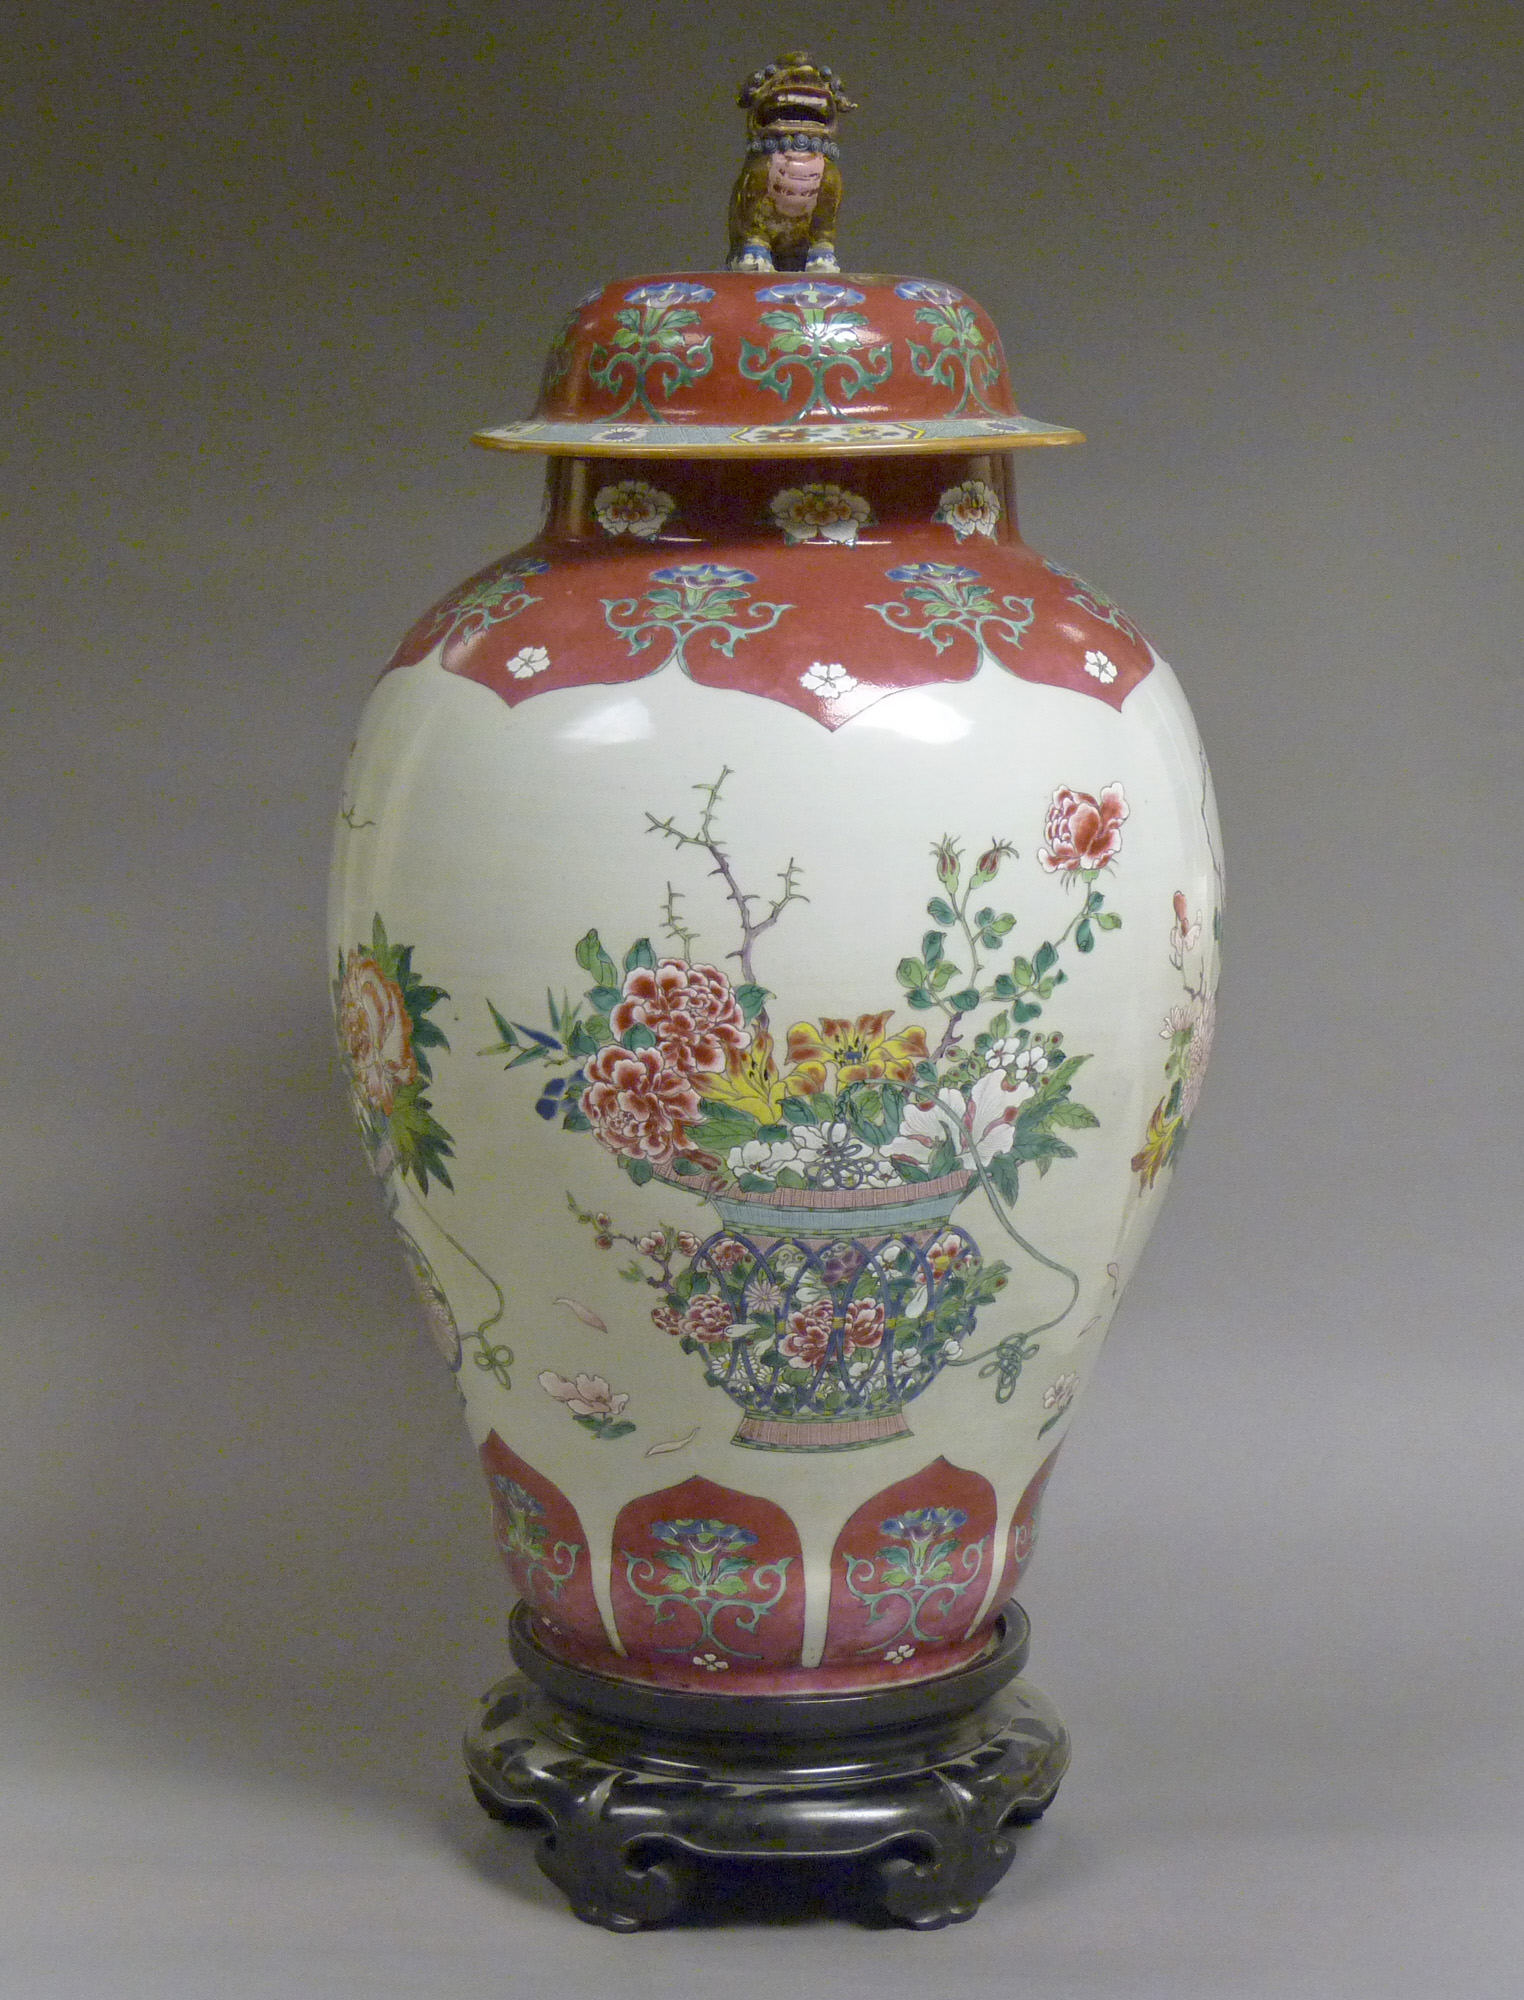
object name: jar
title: Covered jar with baskets of flowers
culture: chinese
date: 1701-1800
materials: enamel, porcelain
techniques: overglaze, painting, polychrome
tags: animals,flowers